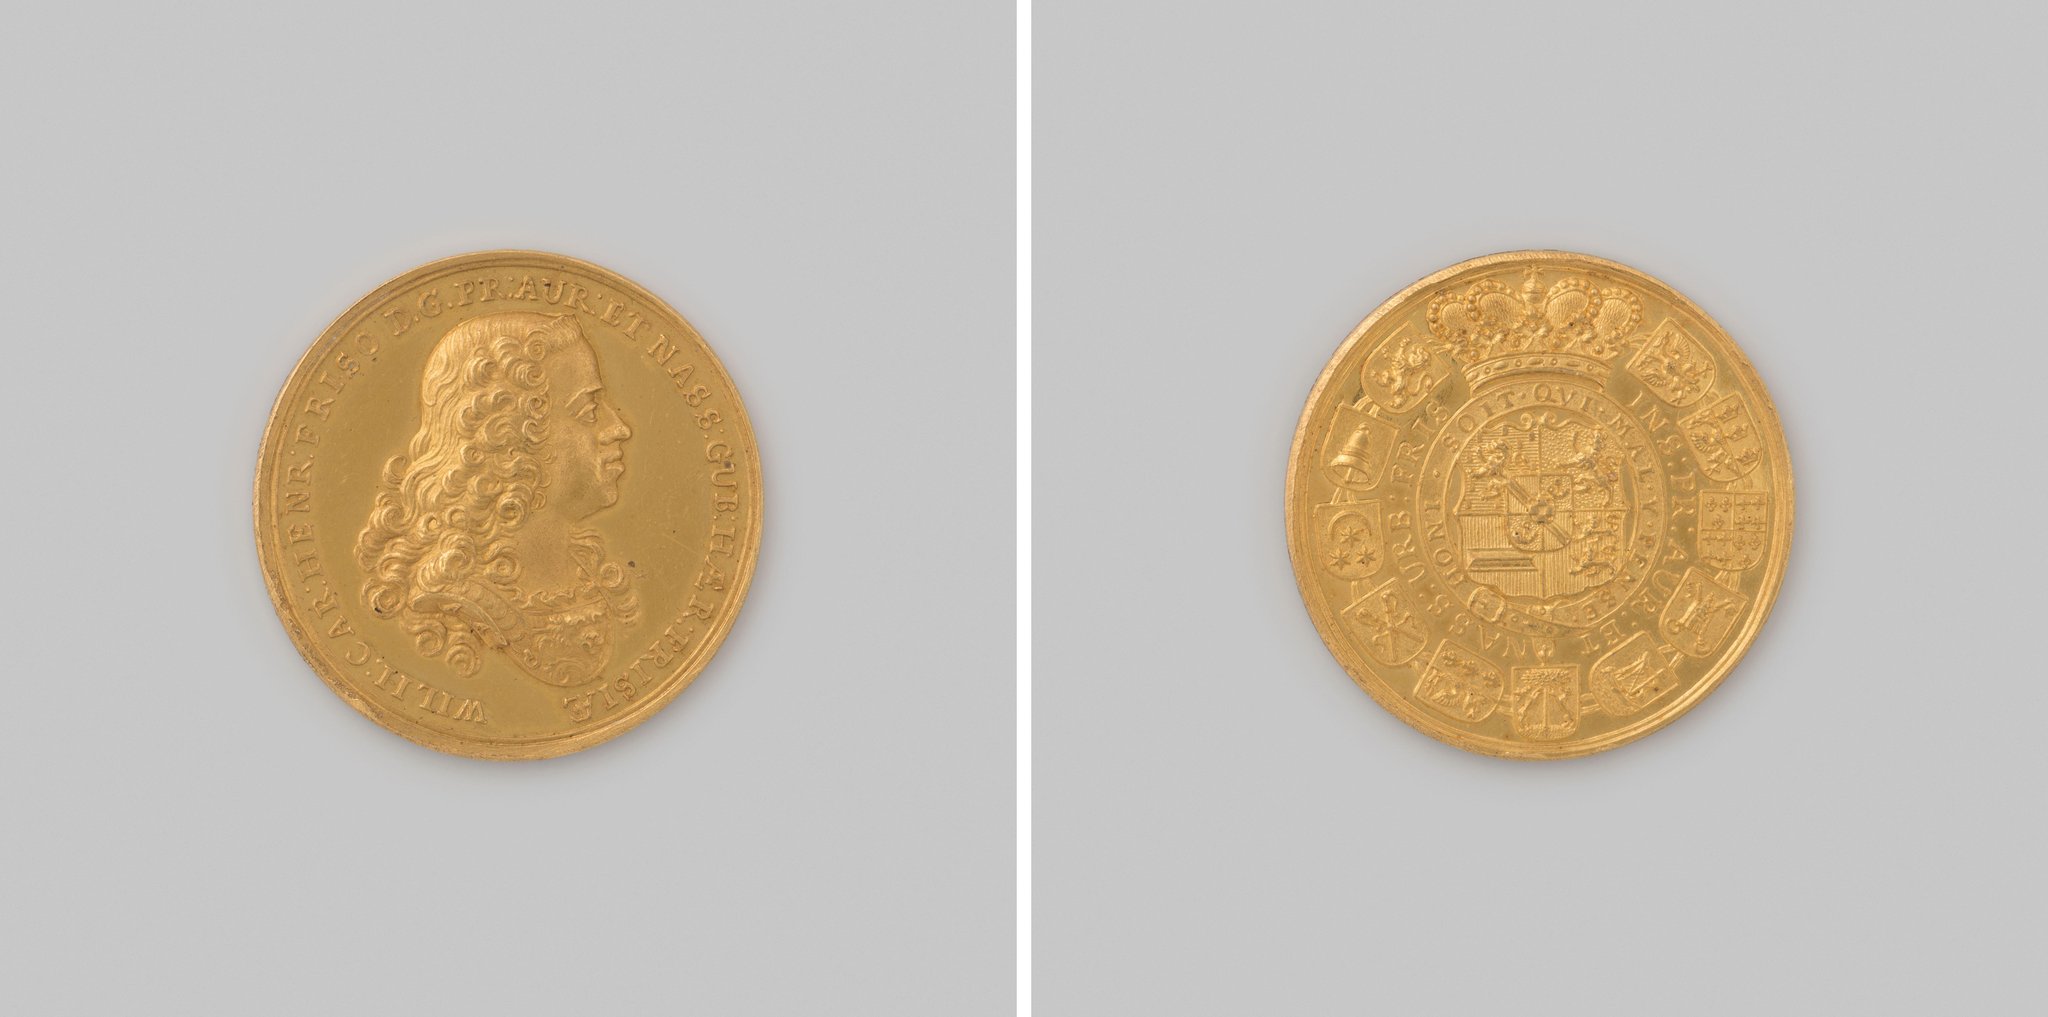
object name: history medal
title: Landdagpenning van Friesland op naam van stadhouder Willem Karel Hendrik Friso 1731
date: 1731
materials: gold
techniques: striking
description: Gouden penning, op de voorzijde het portret van de stadhouder naar rechts met omschrift, op de keerzijde het gekroonde stadhouderlijke wapen omhangen met een kouseband, met omschrift, waarbuiten een lint met de wapenschilden van de elf Friese steden.